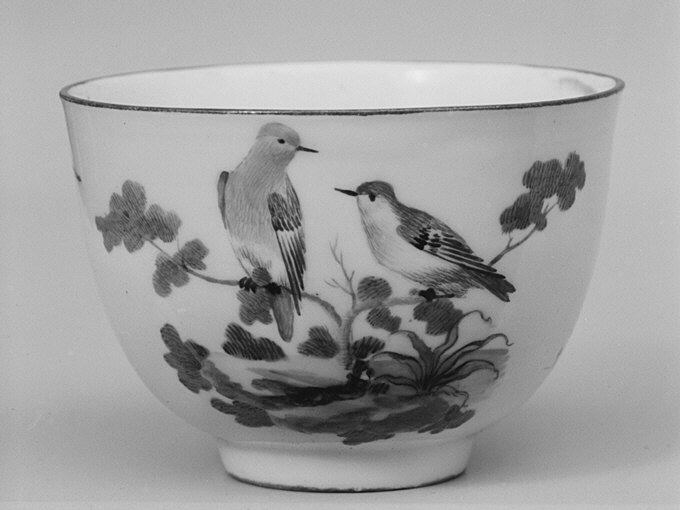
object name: cup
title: Cup (part of a service)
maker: frankenthal porcelain manufactory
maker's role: manufactory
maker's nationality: german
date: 1770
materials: hard paste porcelain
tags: birds,trees